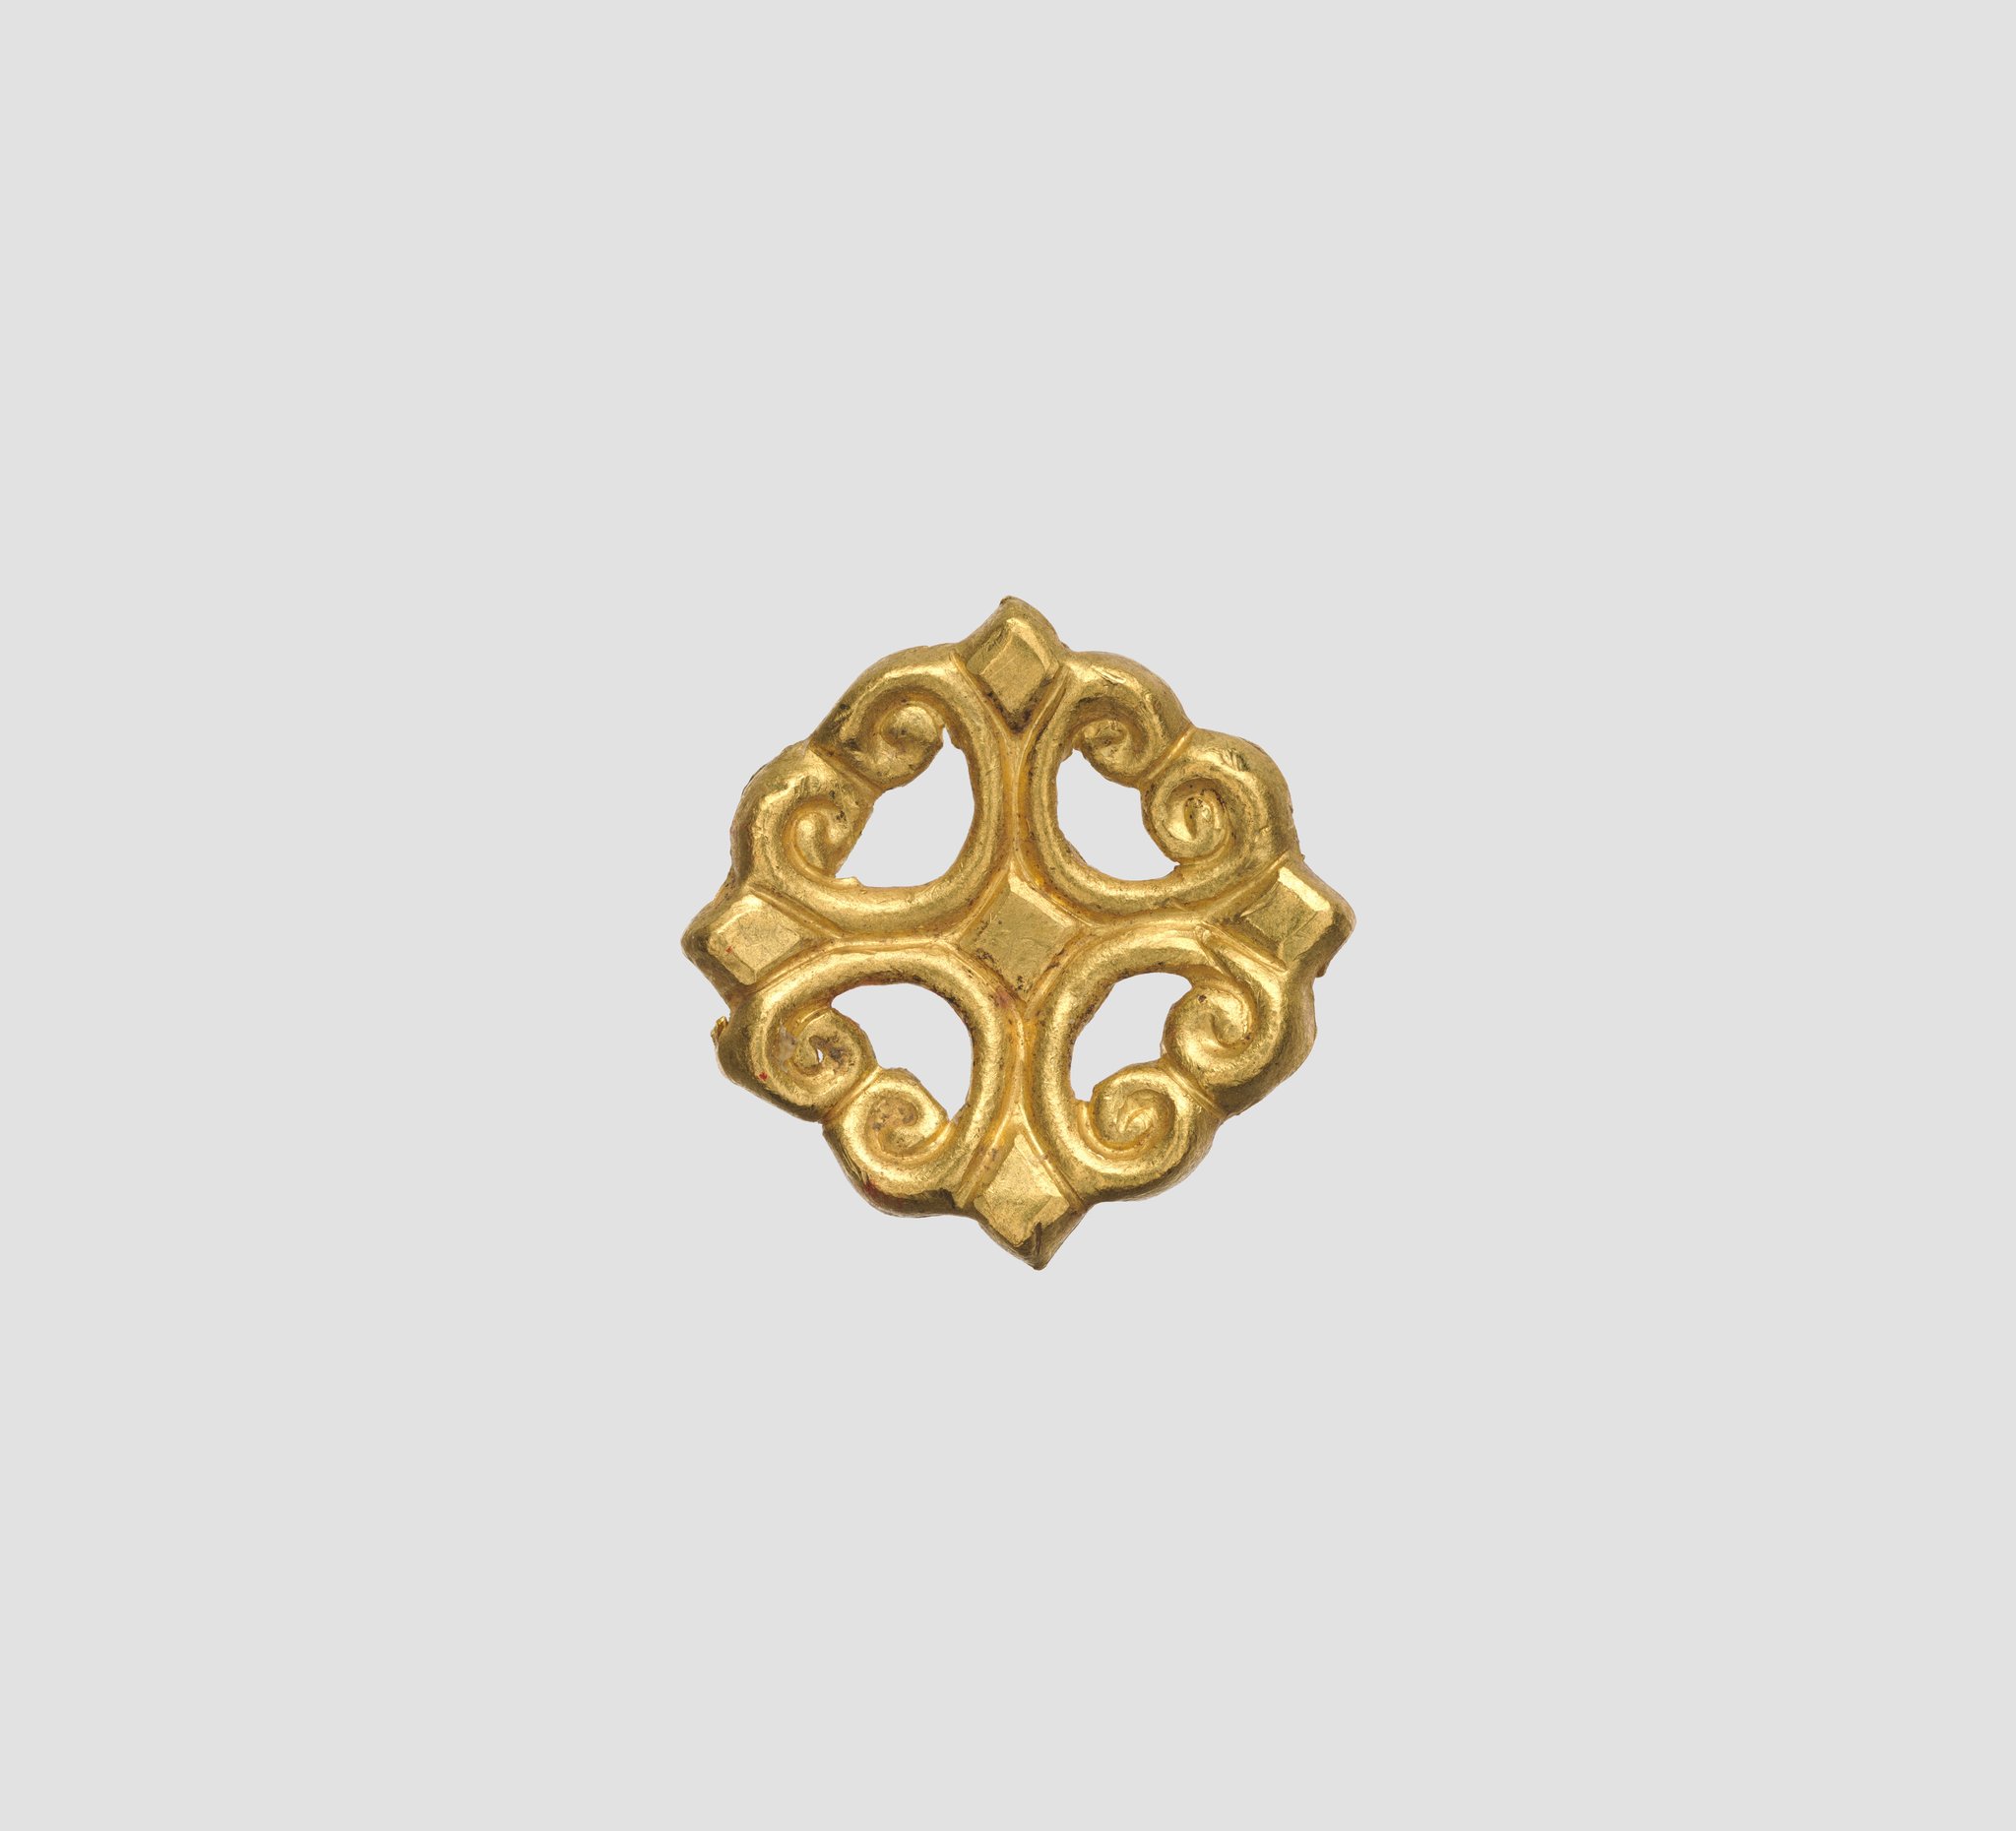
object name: dress ornament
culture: scythian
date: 500-401 BCE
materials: gold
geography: northern black sea region